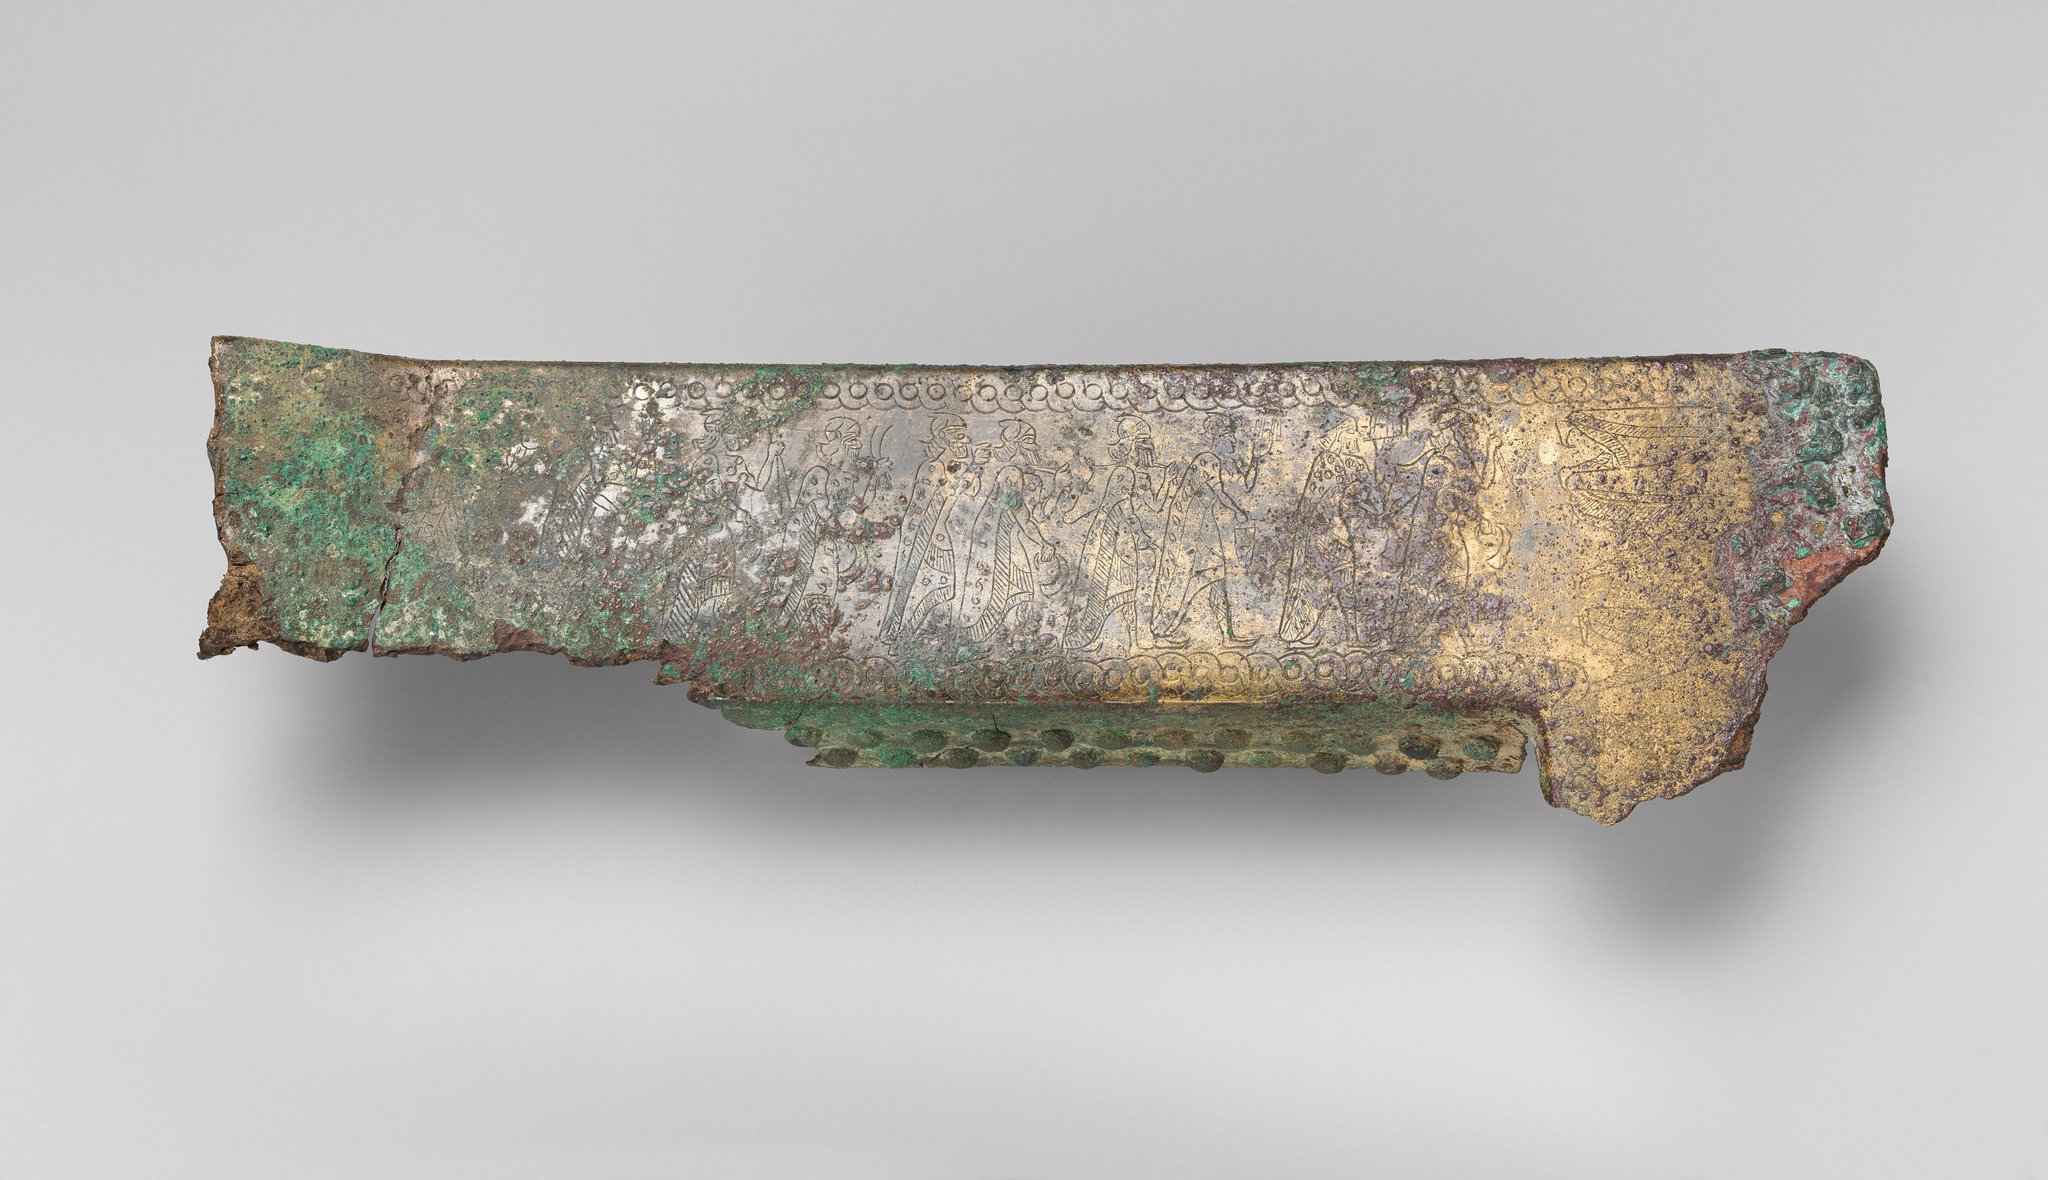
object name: coffin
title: Fragment of a coffin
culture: assyrian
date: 734-701 BCE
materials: bronze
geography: iran